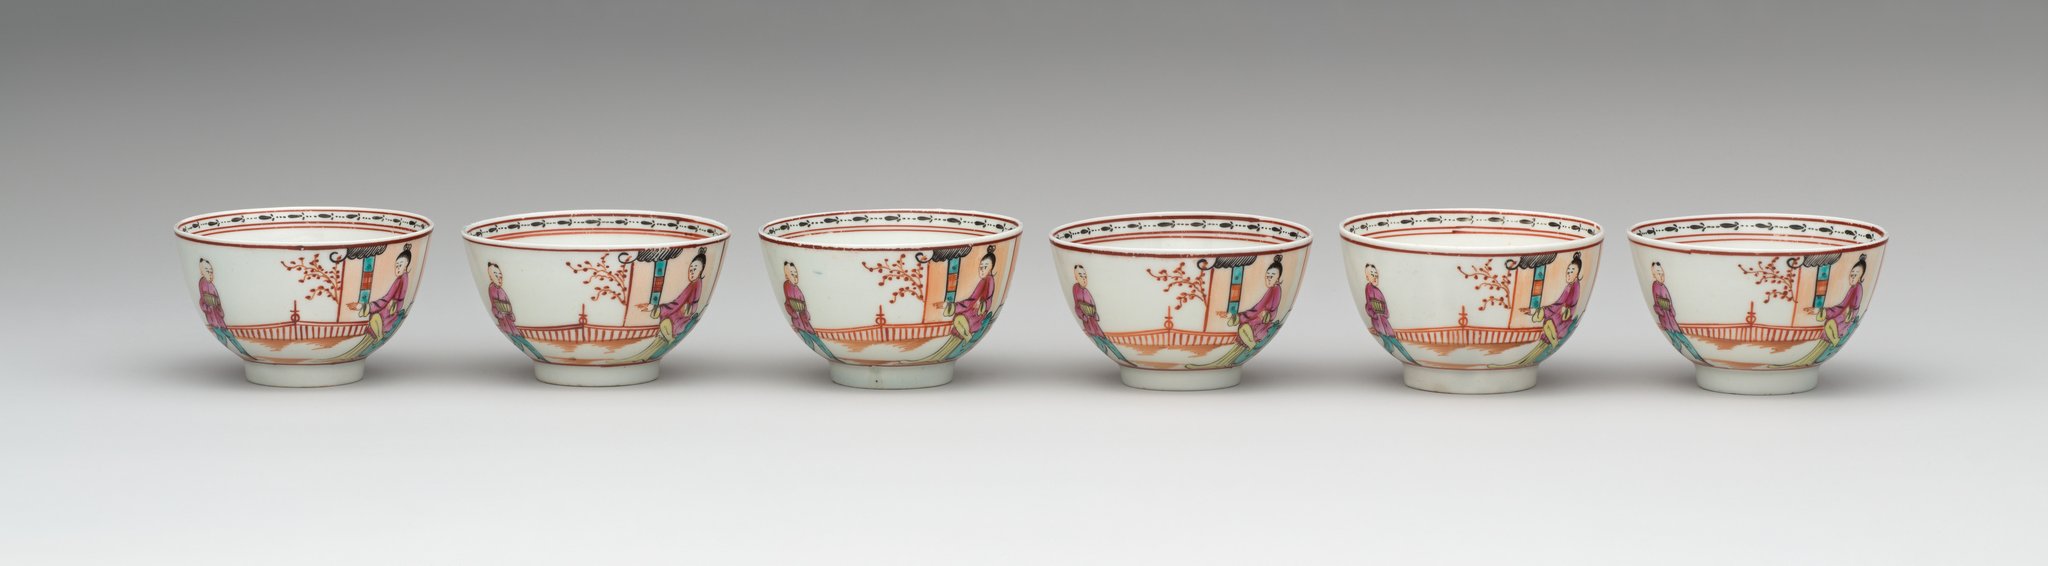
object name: cup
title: Cups (6) (part of a service)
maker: lowestoft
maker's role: factory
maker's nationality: british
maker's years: 1757-1803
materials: soft paste porcelain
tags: boys,girls